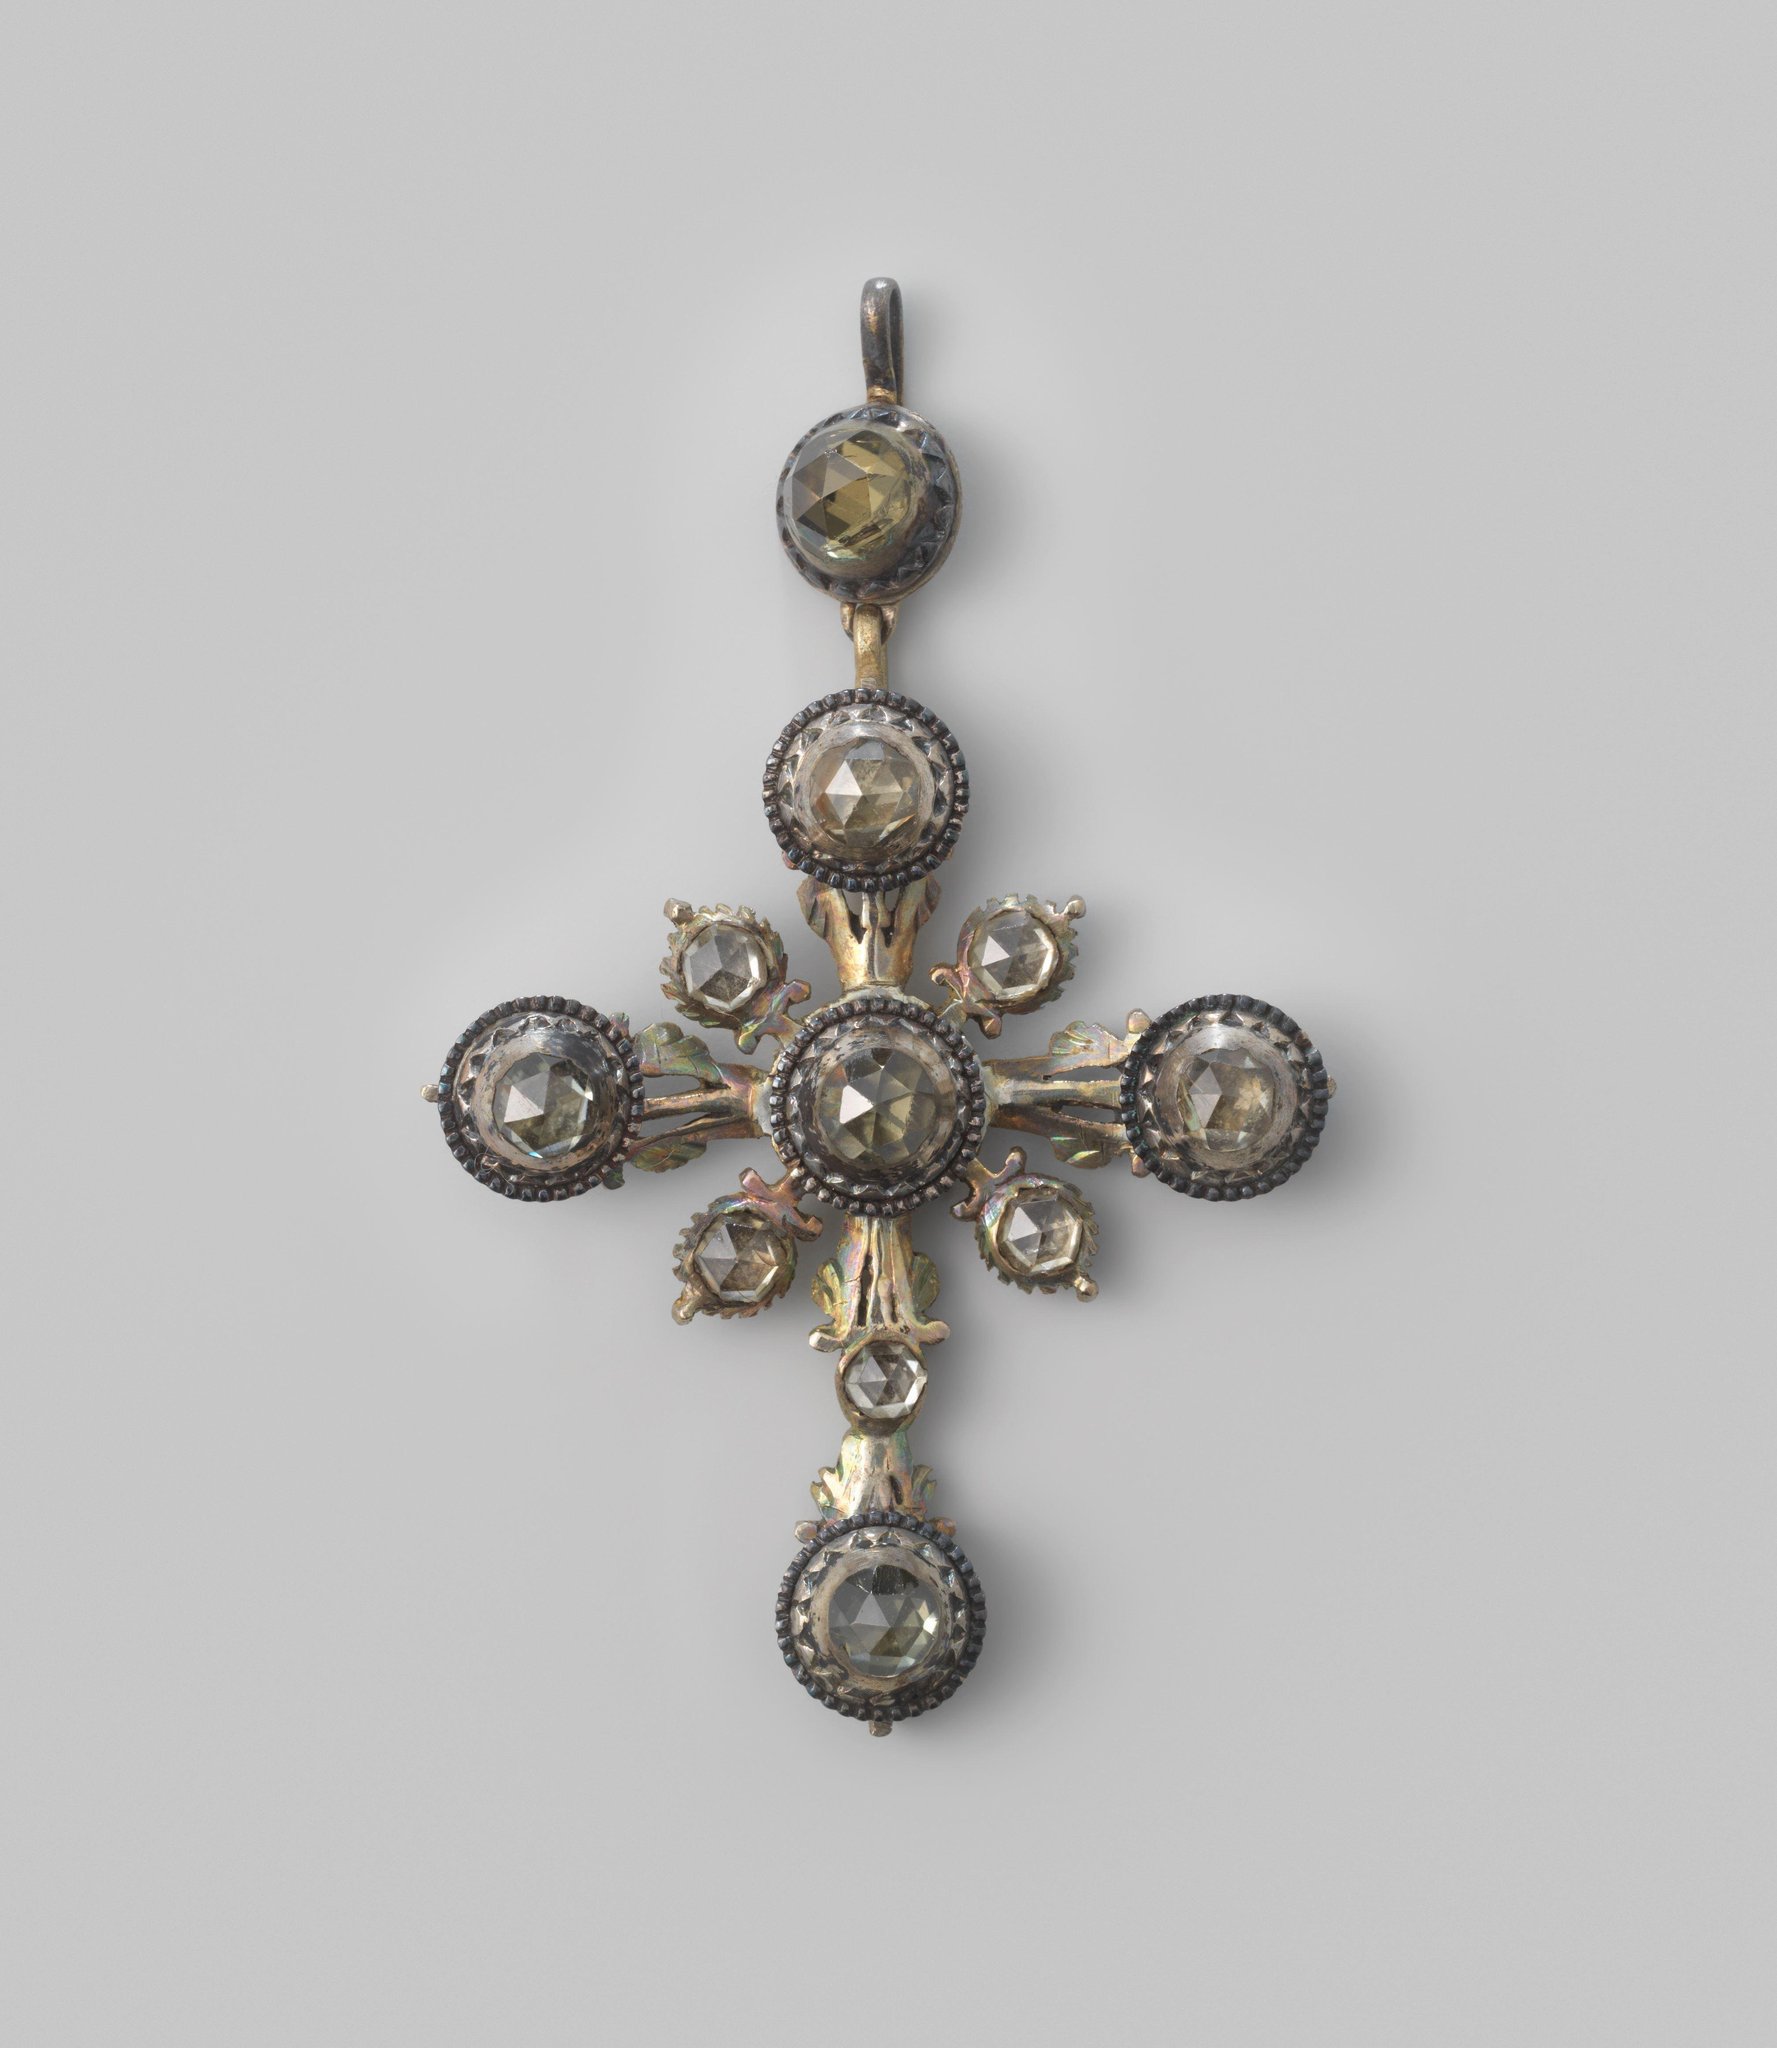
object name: pendant jewelry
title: Hanger in de vorm van een kruis, versierd met elf imitatiediamanten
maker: Anonymous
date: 1675-1700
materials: silver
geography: netherlands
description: Kruisvormige hanger van (verguld) zilver, versierd met zes grote en vijf kleinere imitatie edelstenen. De stenen zijn van glas, op folie en in een dichte kast gezet en voorzien van een rooslijpsel om diamant te imiteren. De zes grote stenen zijn in een zilver kast gezet. De hanger bestaat uit twee onderdelen; aan de bovenzijde van het kruisje zit een schuifhaakje waaraan een enkele glassteen hangt, eveneens voorzien van een schuifhaakje.